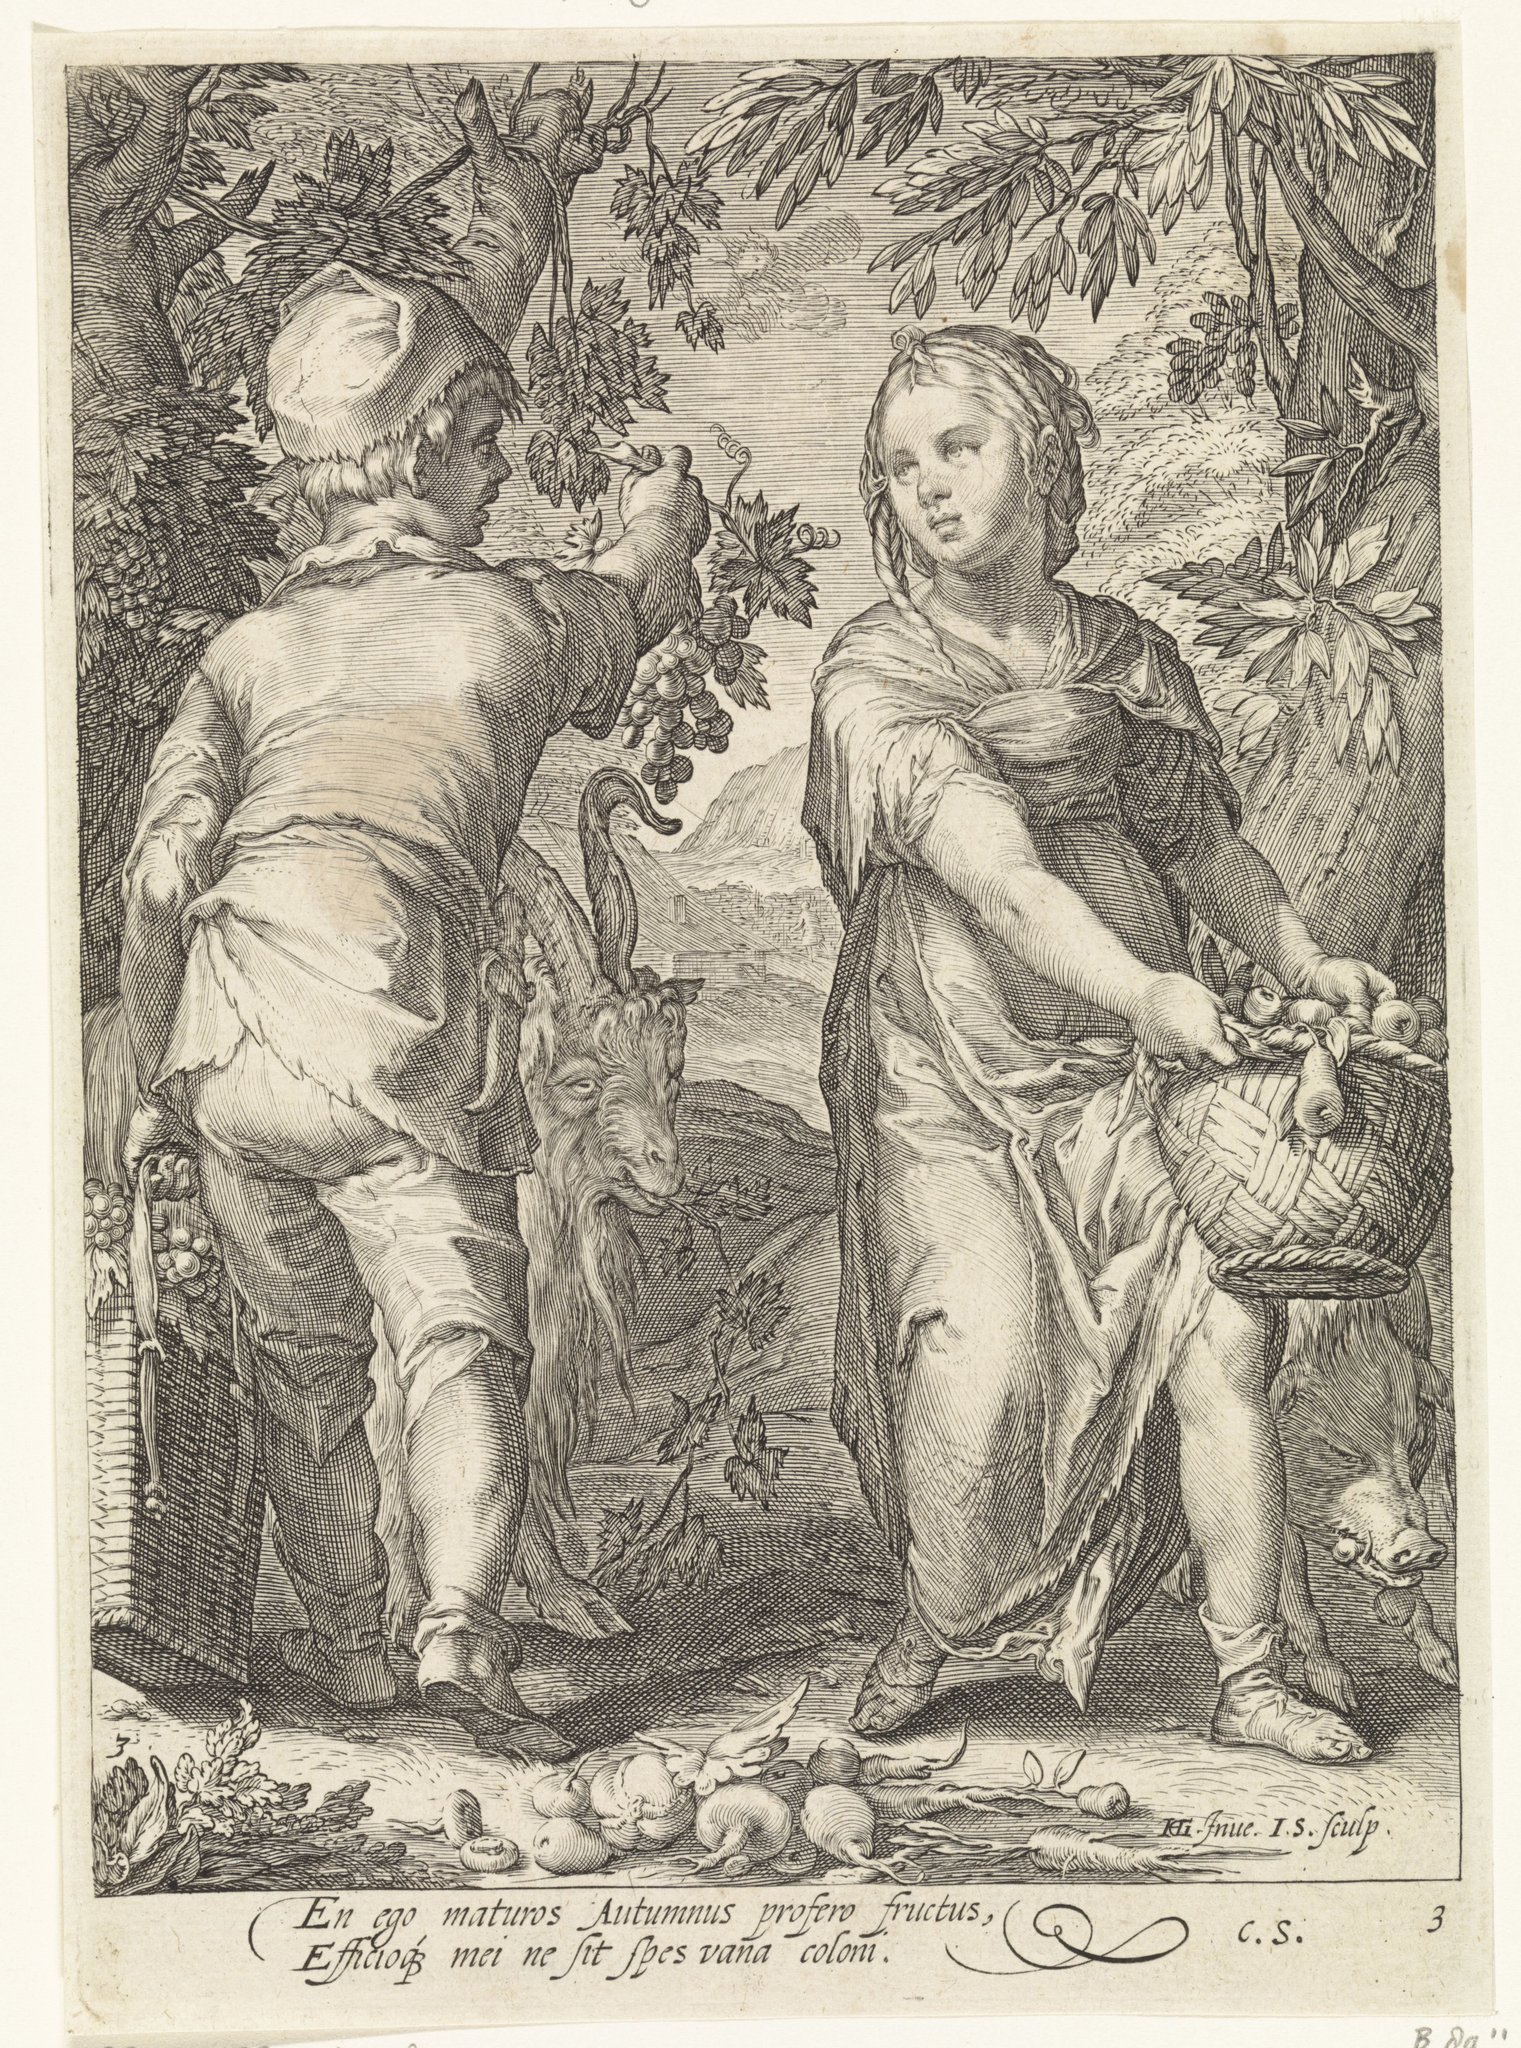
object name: print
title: De vier seizoenen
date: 1601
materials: paper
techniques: engraving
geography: northern netherlands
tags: fruit-tree culture; fruit harvest, boar (male pig), he-goat, billy-goat, vintage, grape harvest, autumn, fall, 'autumnus'; 'autunno' (ripa)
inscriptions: collector's mark: Lugt 2228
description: Een jongen en een meisje oogsten fruit in het bijzijn van een bok en een zwijn. De jongen plukt druiven, het meisje draagt een mand met peren.